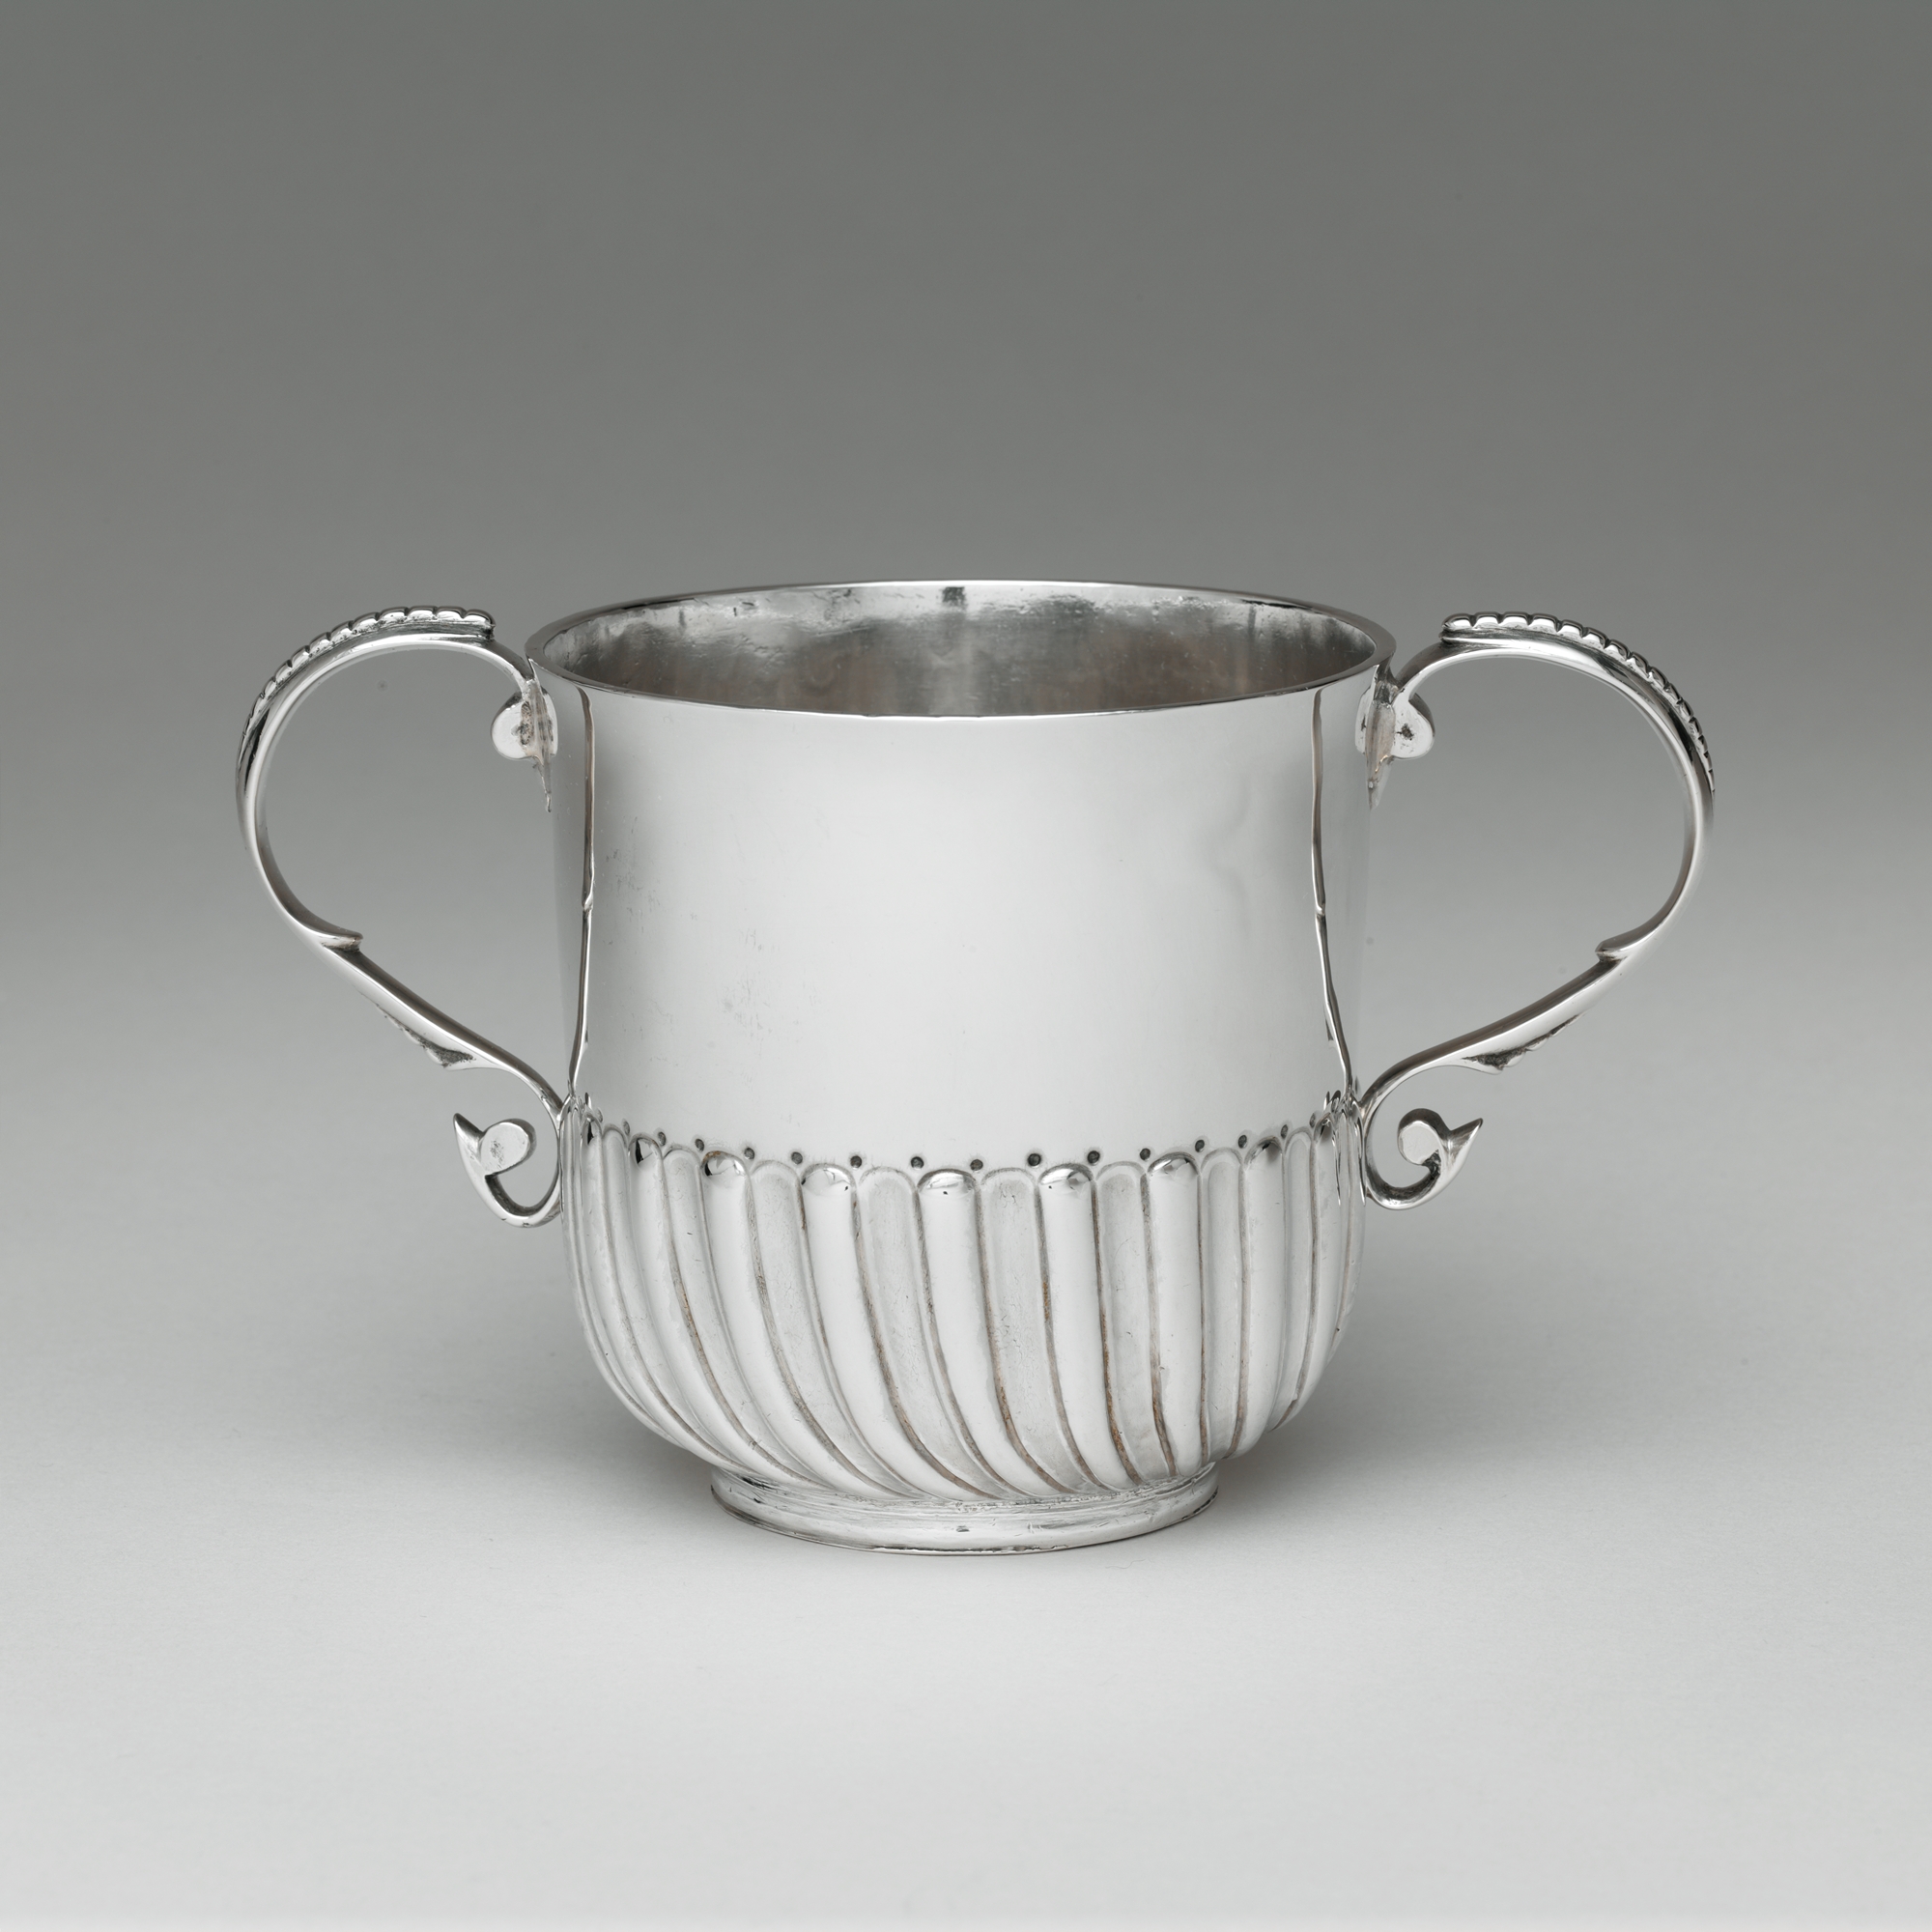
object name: cup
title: Two-handled Cup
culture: american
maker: william cowell sr.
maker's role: maker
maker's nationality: american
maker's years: 1682-1736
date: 1705-1715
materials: silver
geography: united states